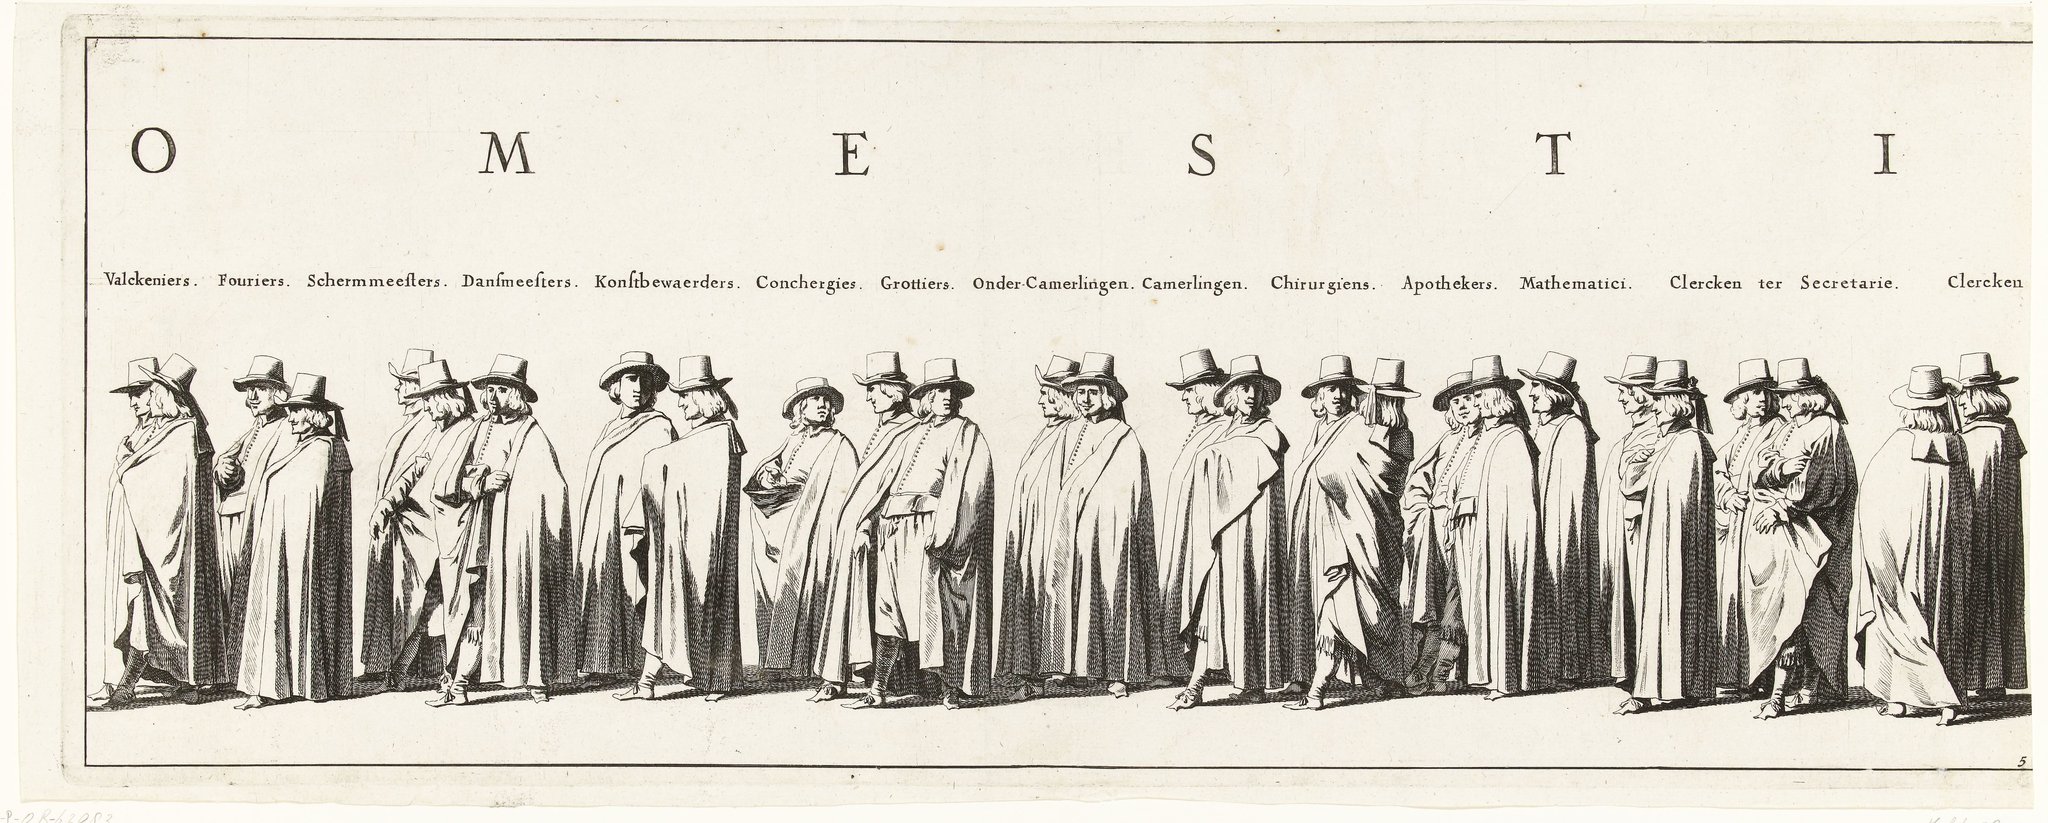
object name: print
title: Begraeffenisse van Syne Hoogheyt Frederick Henrick, by der Gratien Gods Prince van Orange, Grave van Nassau &c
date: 1647-1651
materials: paper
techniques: etching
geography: amsterdam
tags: delft, the hague, frederick henry (prince of orange), cortege, funeral procession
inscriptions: collector's mark: Lugt 2228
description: De begrafenisstoet van stadhouder Frederik Hendrik te 's-Gravenhage op 10 mei 1647. Plaat nr. 5 met een deel van de stoet, boven de personen staat hun functie. Onderdeel van een serie van 30 platen en 20 tekstbladen, bedoeld om aan elkaar geplakt te worden.